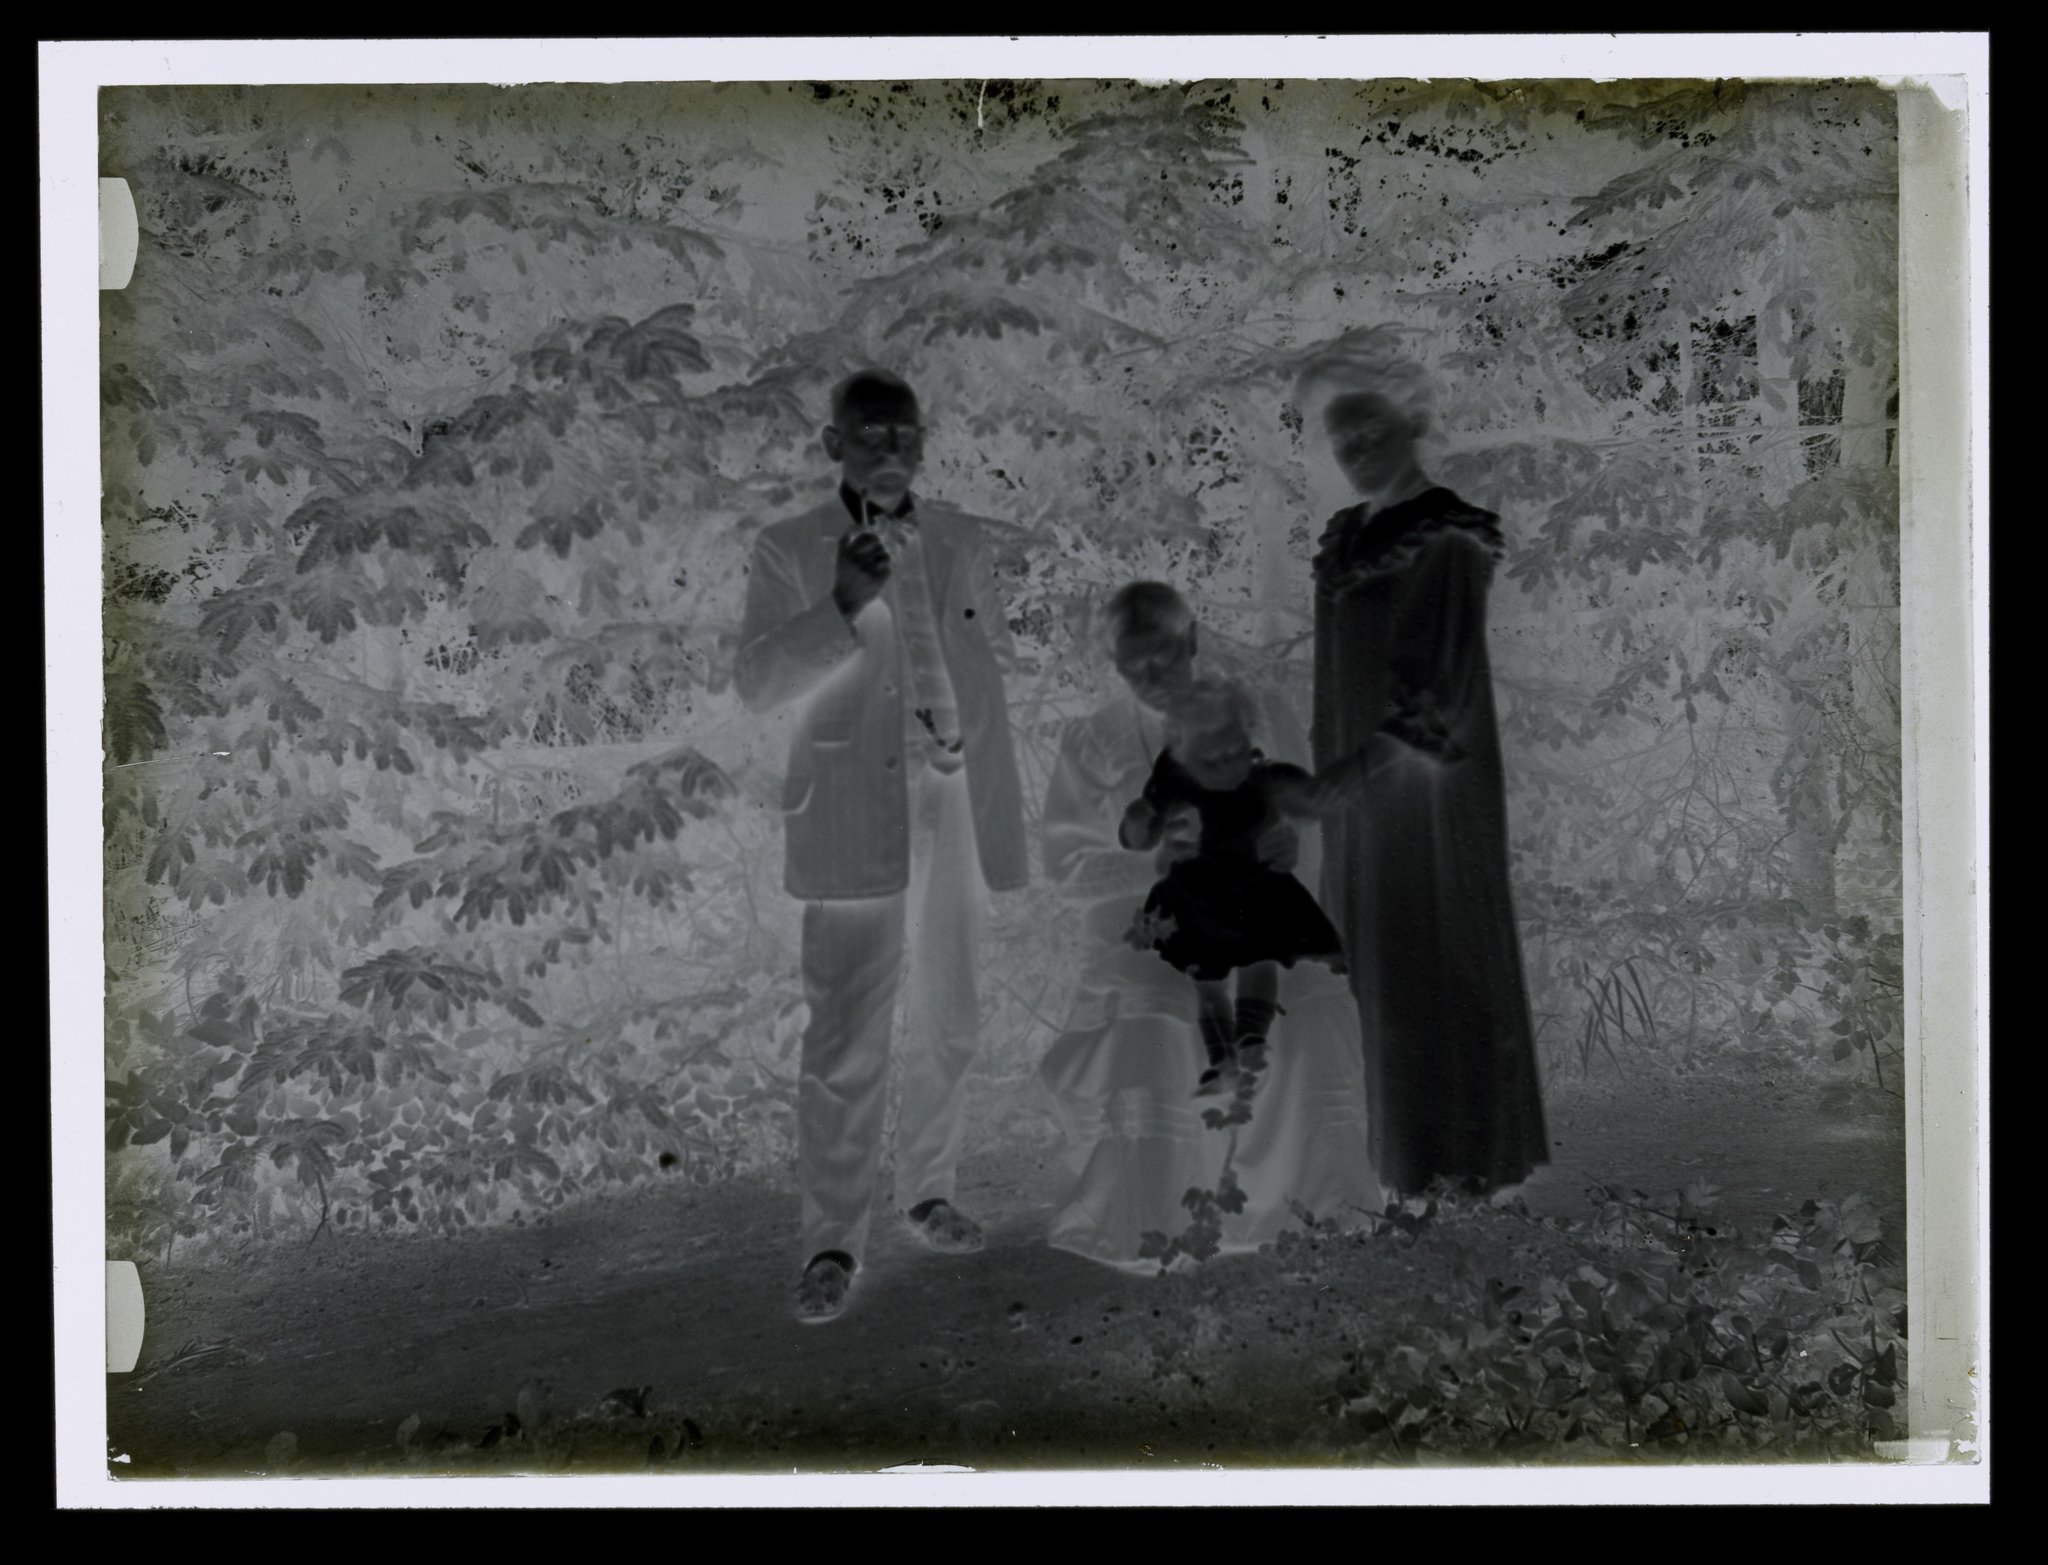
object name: glasnegatief, glasplaatnegatief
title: Groepsportret van een onbekende man, twee vrouwen en een kind in een tuin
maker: laurens lodewijk kleijn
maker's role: draughtsman, painter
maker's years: 1826-1909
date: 1865-1900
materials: glass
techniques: collodion process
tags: garden, anonymous historical persons portrayed in a group, in a group-portrait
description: Onderdeel van groep glasnegatieven uit de nalatenschap van de schilder Laurens Lodewijk Kleijn, stillevens, portretten, zelfportretten en kunstreproducties.